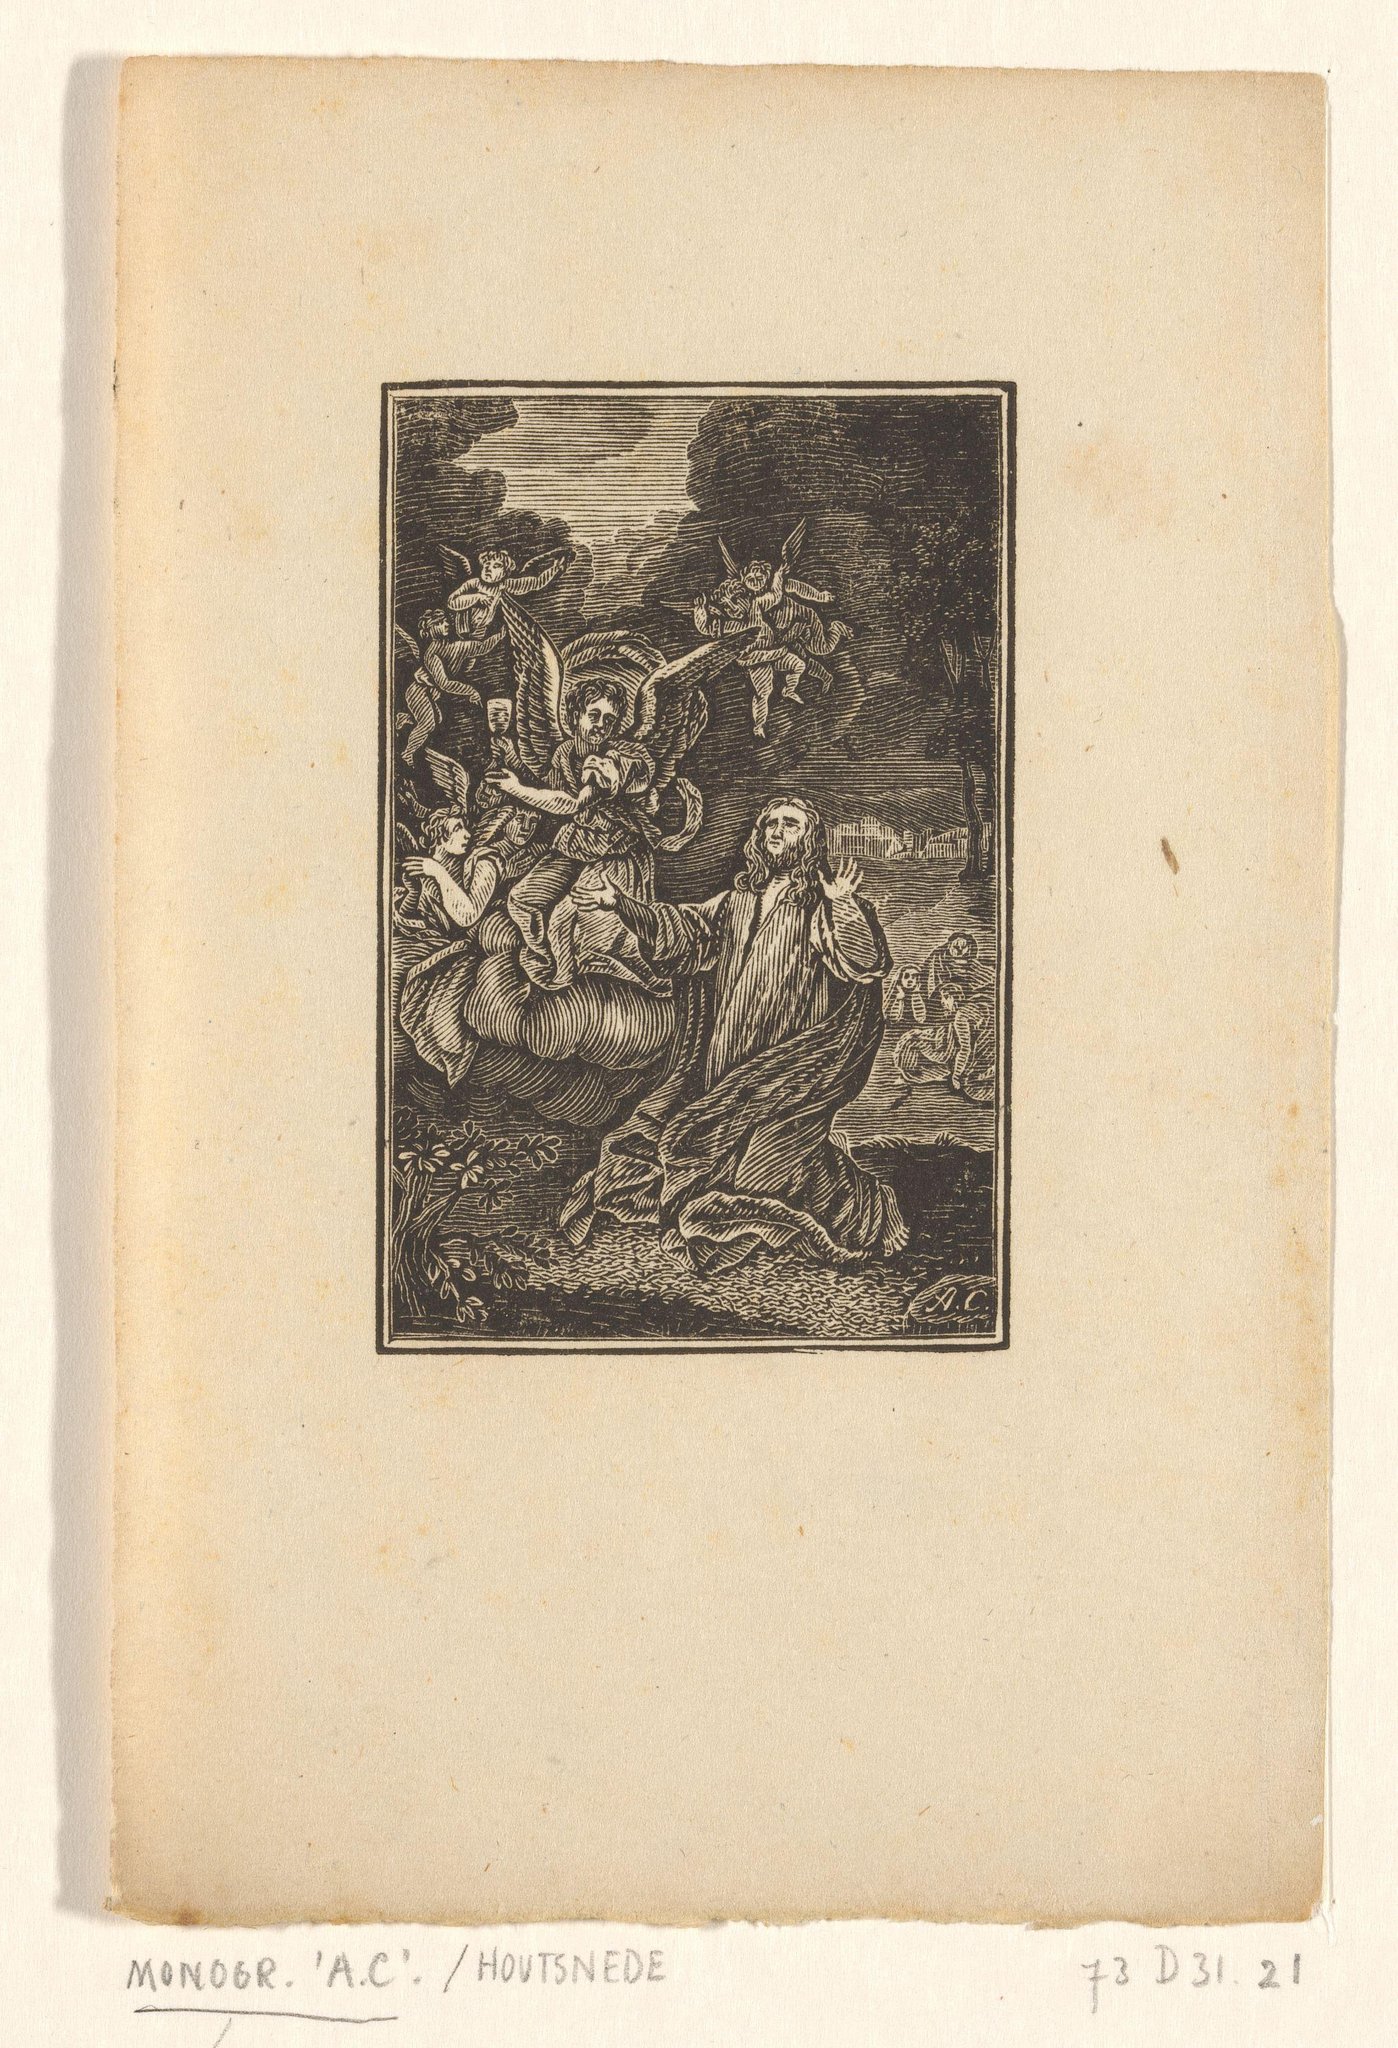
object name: print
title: Christus op de Olijfberg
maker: monogrammist ac (houtgraveur)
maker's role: print maker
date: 1800-1899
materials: paper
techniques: woodcut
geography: netherlands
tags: agony of christ: to comfort him one or more angels appear to christ with chalice and/or cross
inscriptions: collector's mark: Lugt 2228